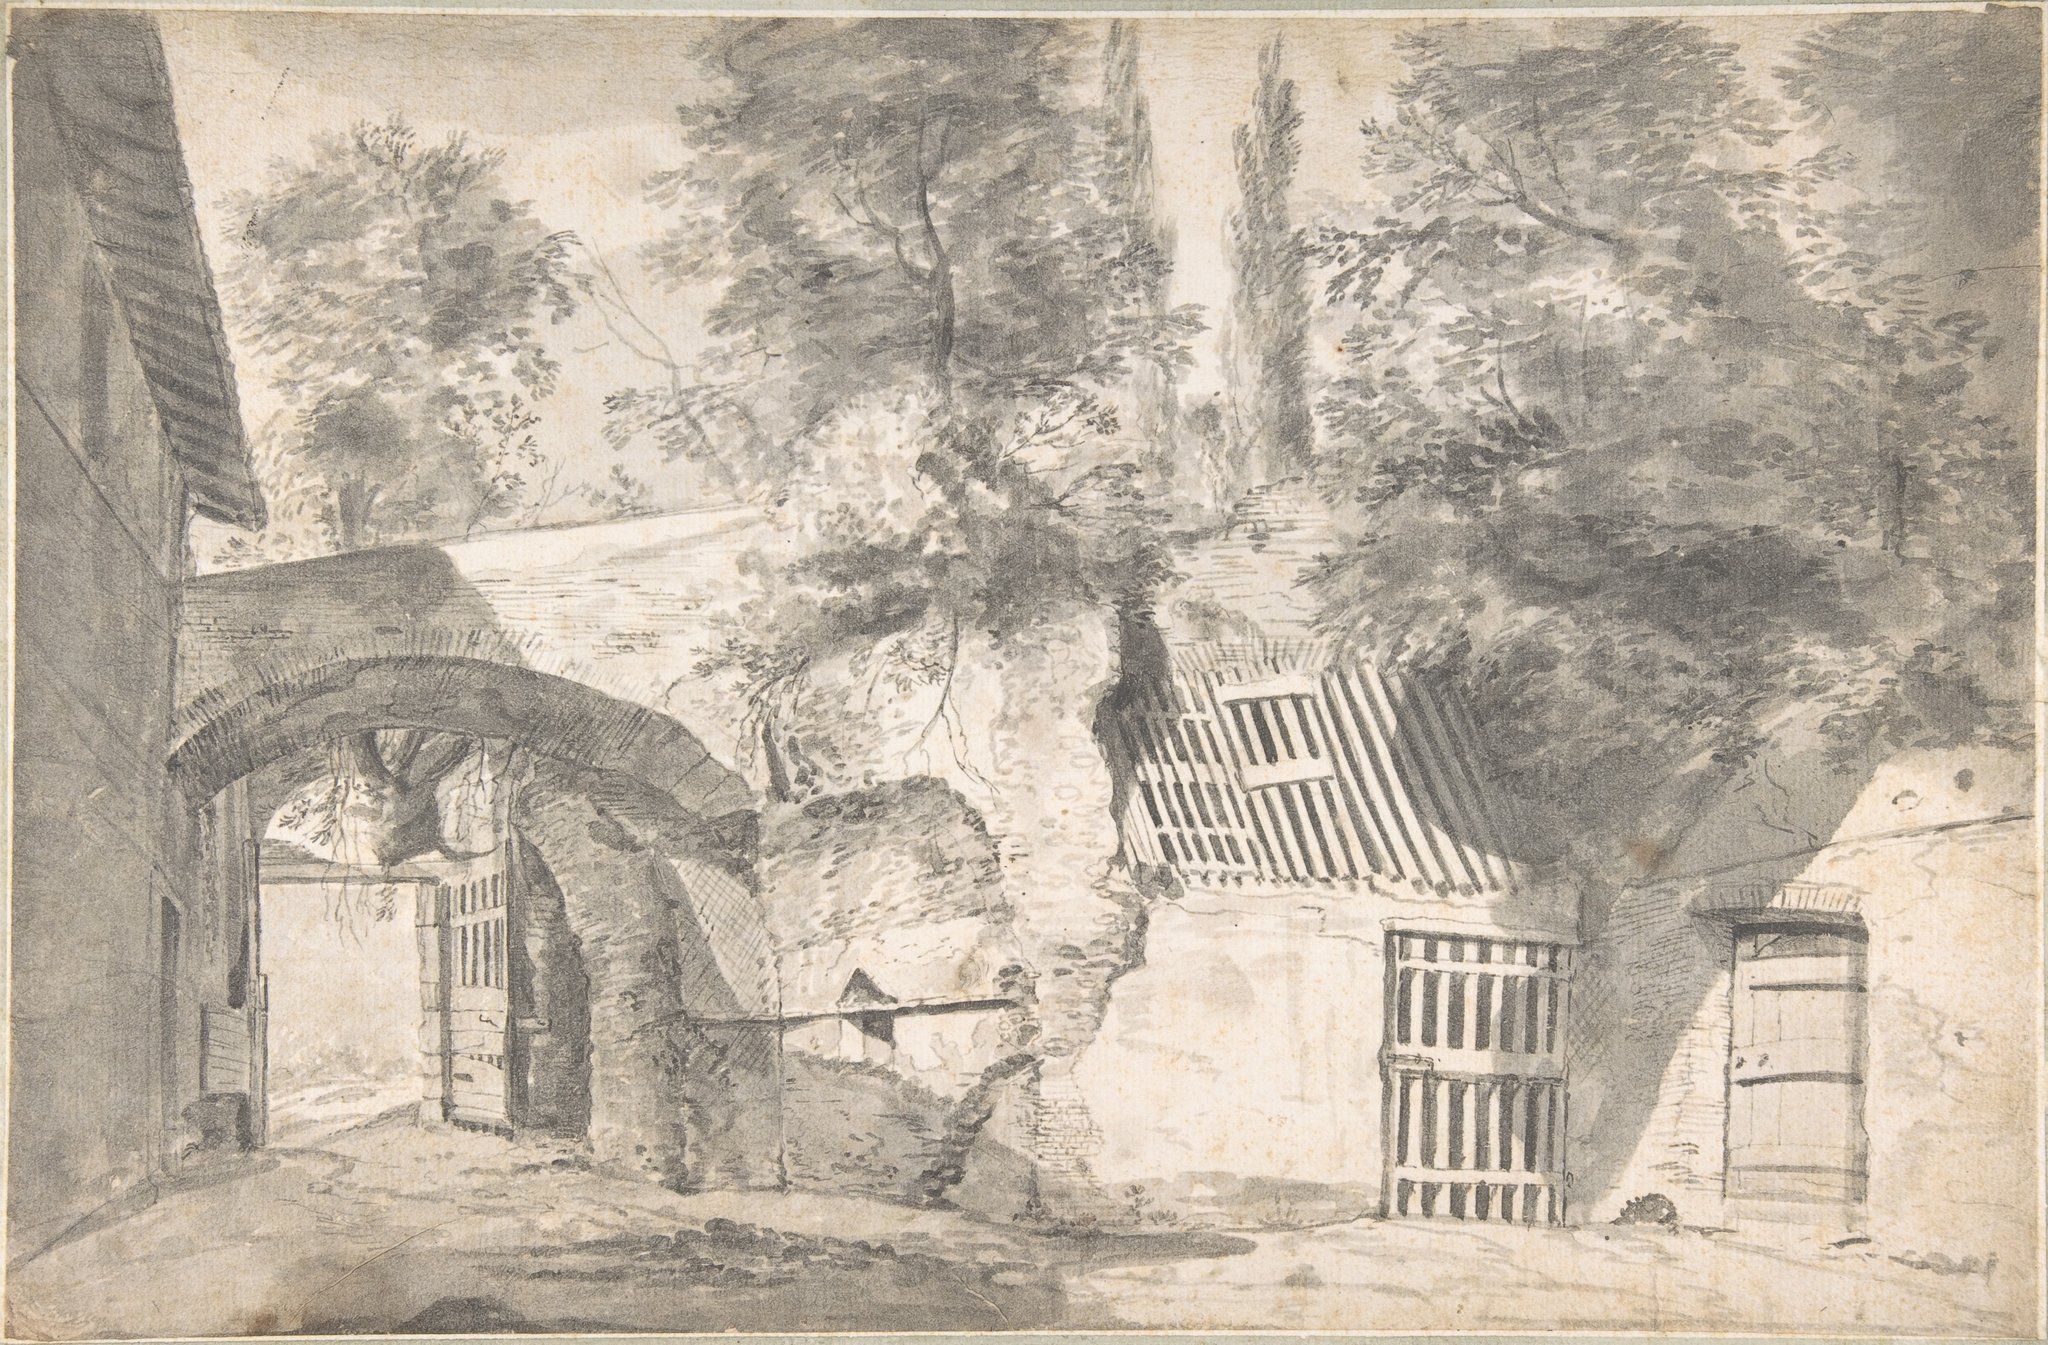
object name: drawing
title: Courtyard of a Farmhouse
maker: thomas wijck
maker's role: artist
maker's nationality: dutch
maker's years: 1616-1677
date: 1629-1677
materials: chalk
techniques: brush, wash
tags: doorways,houses,courtyards,trees